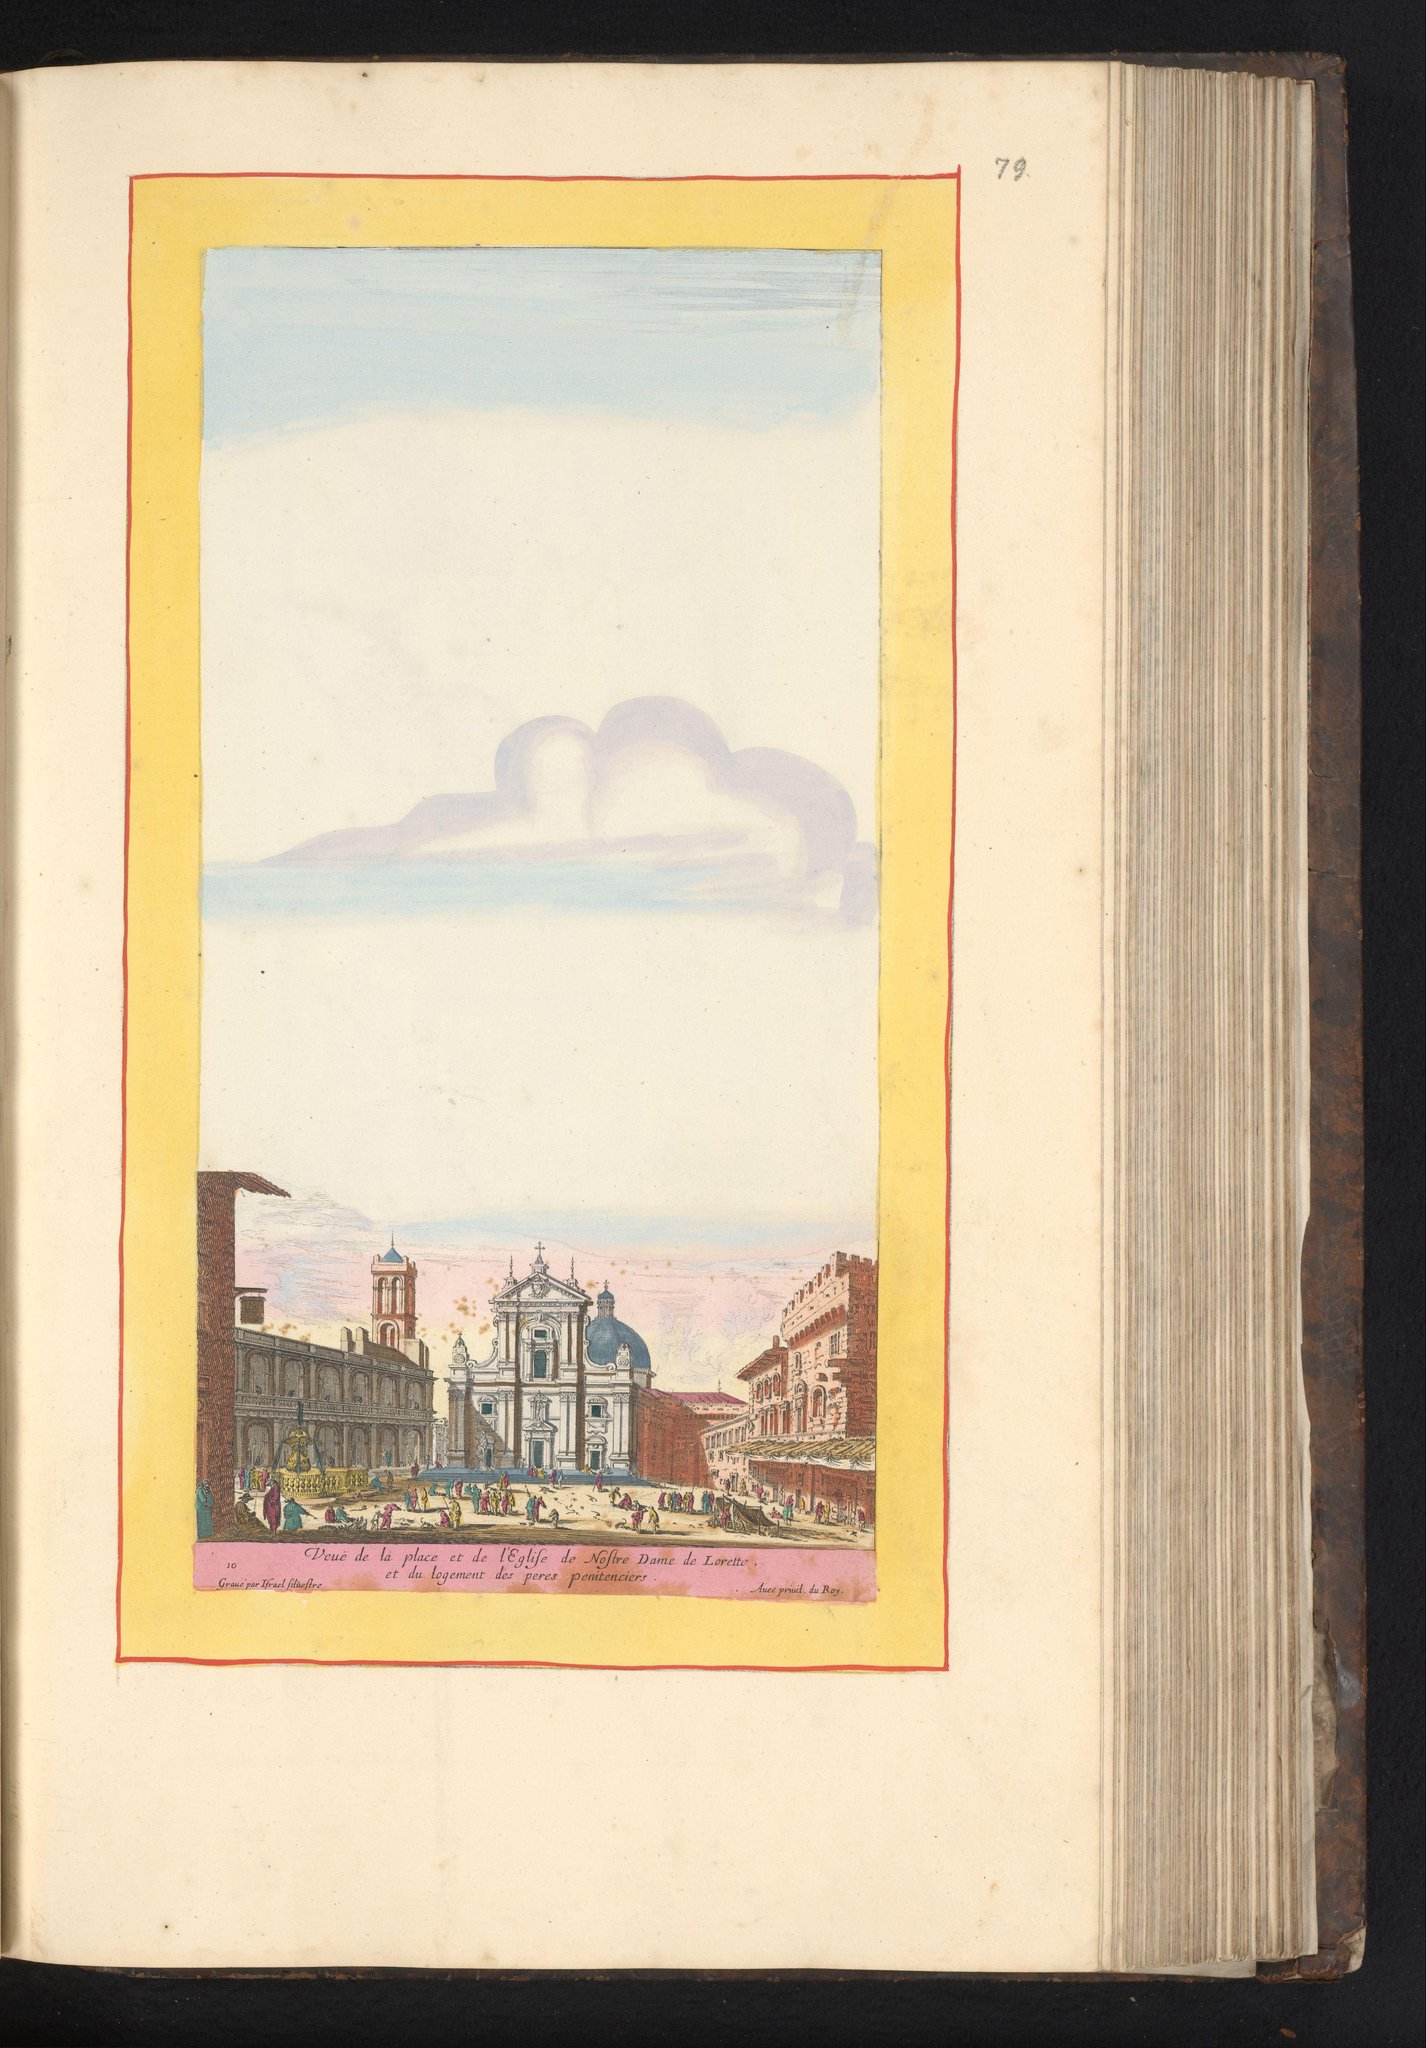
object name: album leaf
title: Basilica della Santa Casa te Loreto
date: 1631-1691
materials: paper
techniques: colour, etching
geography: the hague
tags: city-view, and landscape with man-made constructions, church (exterior)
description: Prent maakt deel uit van een reeks van 12 prenten met gezichten op plekken in Italië. De prent is langs de bovenrand van de voorstelling afgescheurd. De voorstelling is aan de bovenzijde aangevuld met een geschilderde lucht.